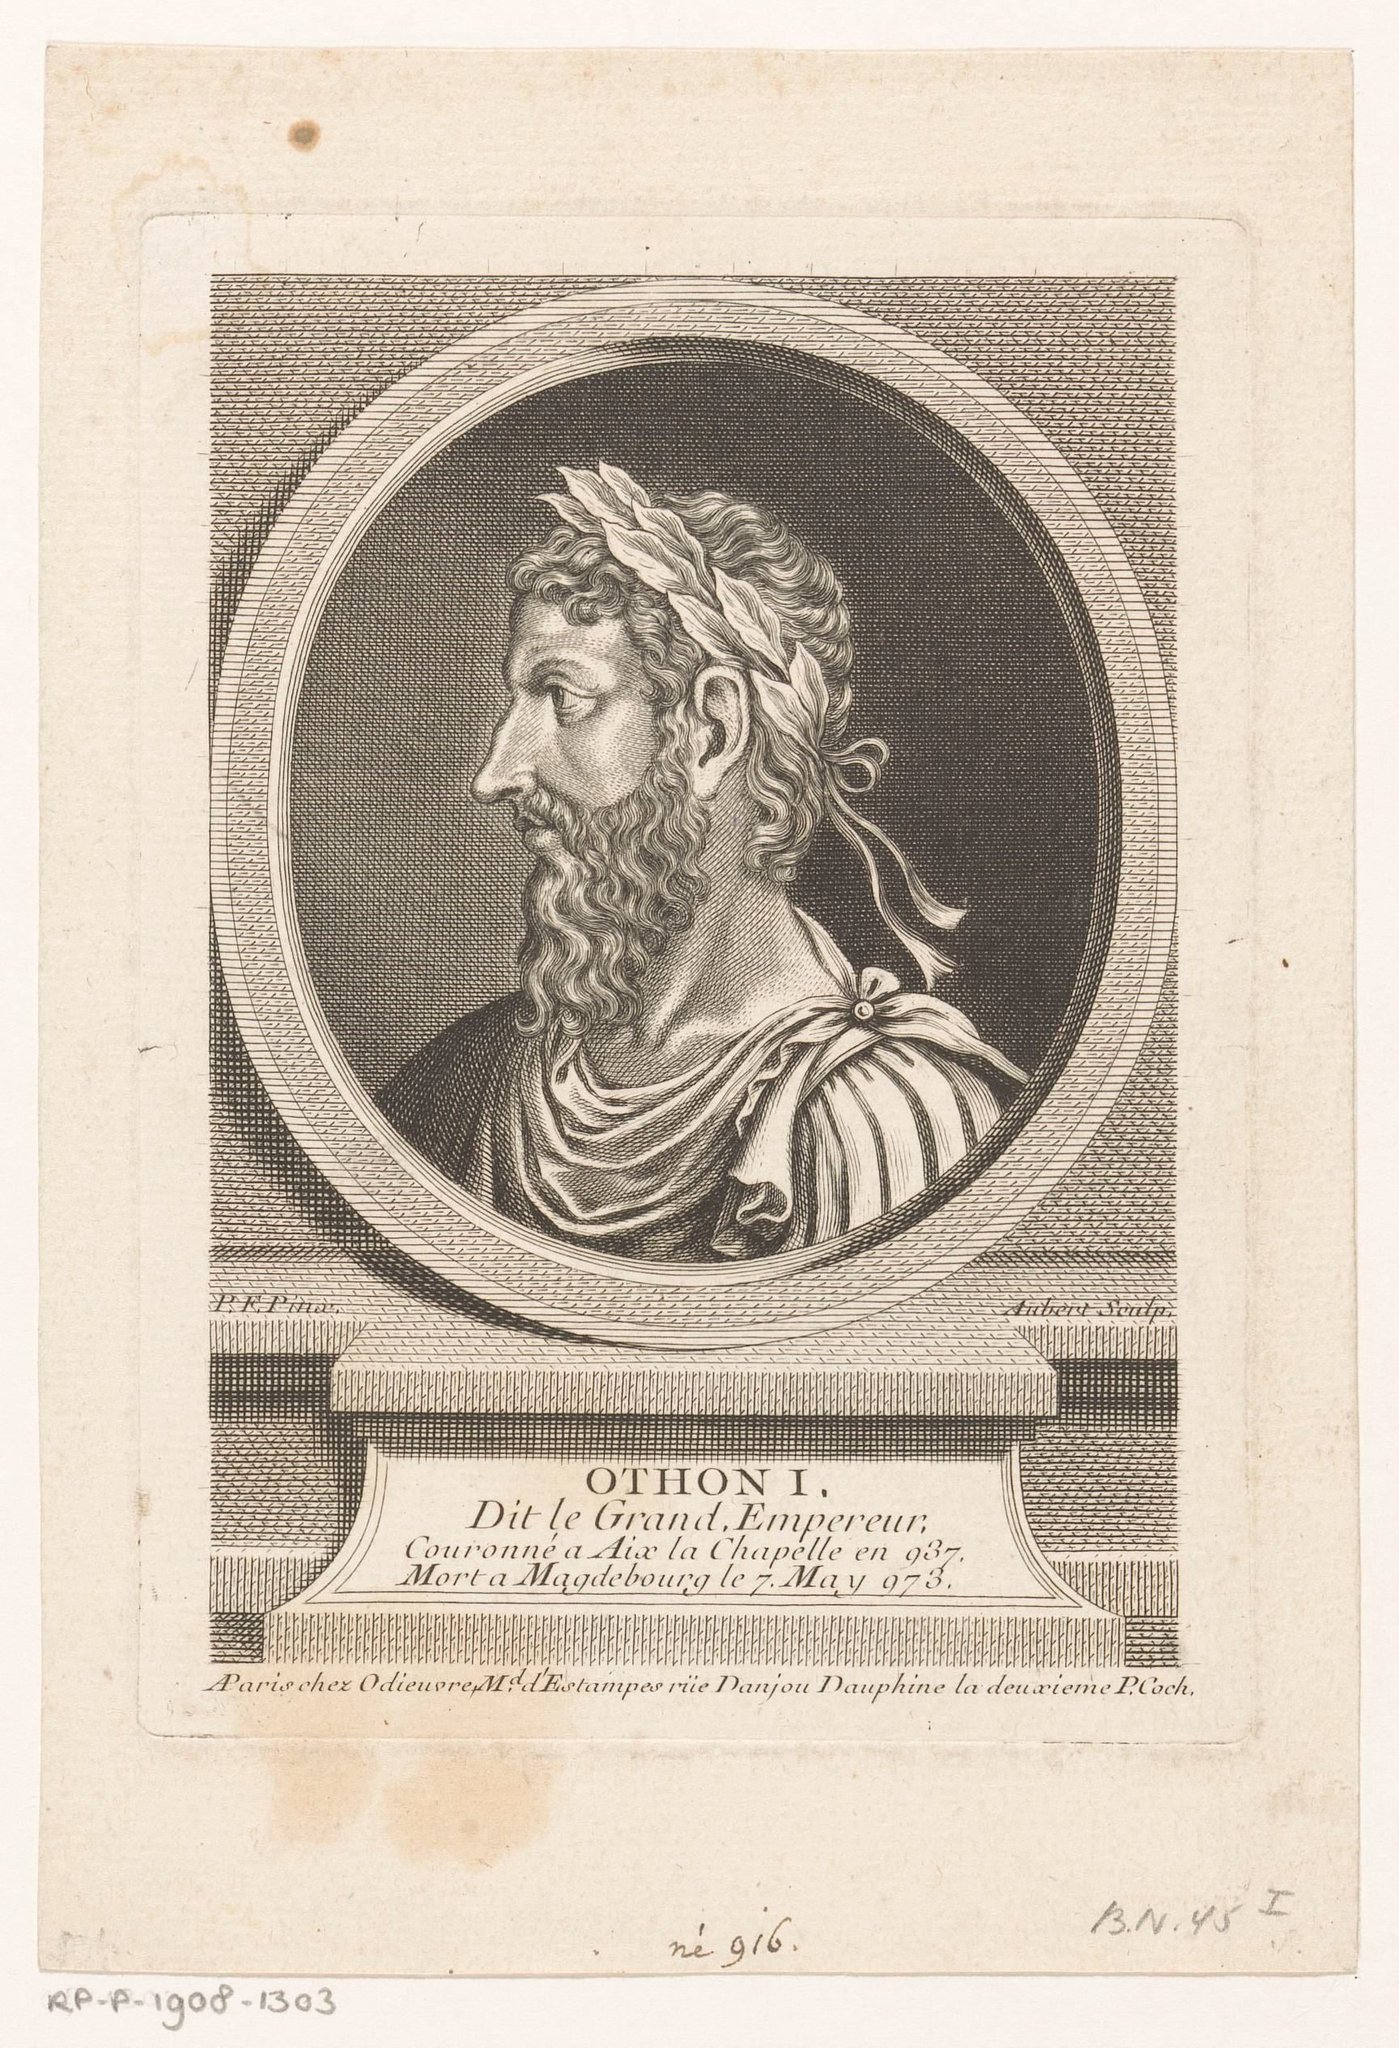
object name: book illustration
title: Othon I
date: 1755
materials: paper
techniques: engraving, etching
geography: paris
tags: historical persons, crowning with laurel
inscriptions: inscription: ‘né 916.’, collector's mark: Lugt 2228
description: Prent uit M. Dreux du Radier. L'Europe illustre, contenant l'histoire abregée (...). Parijs: M. Oudrieuve, A.-F. Le Breton, 1755.